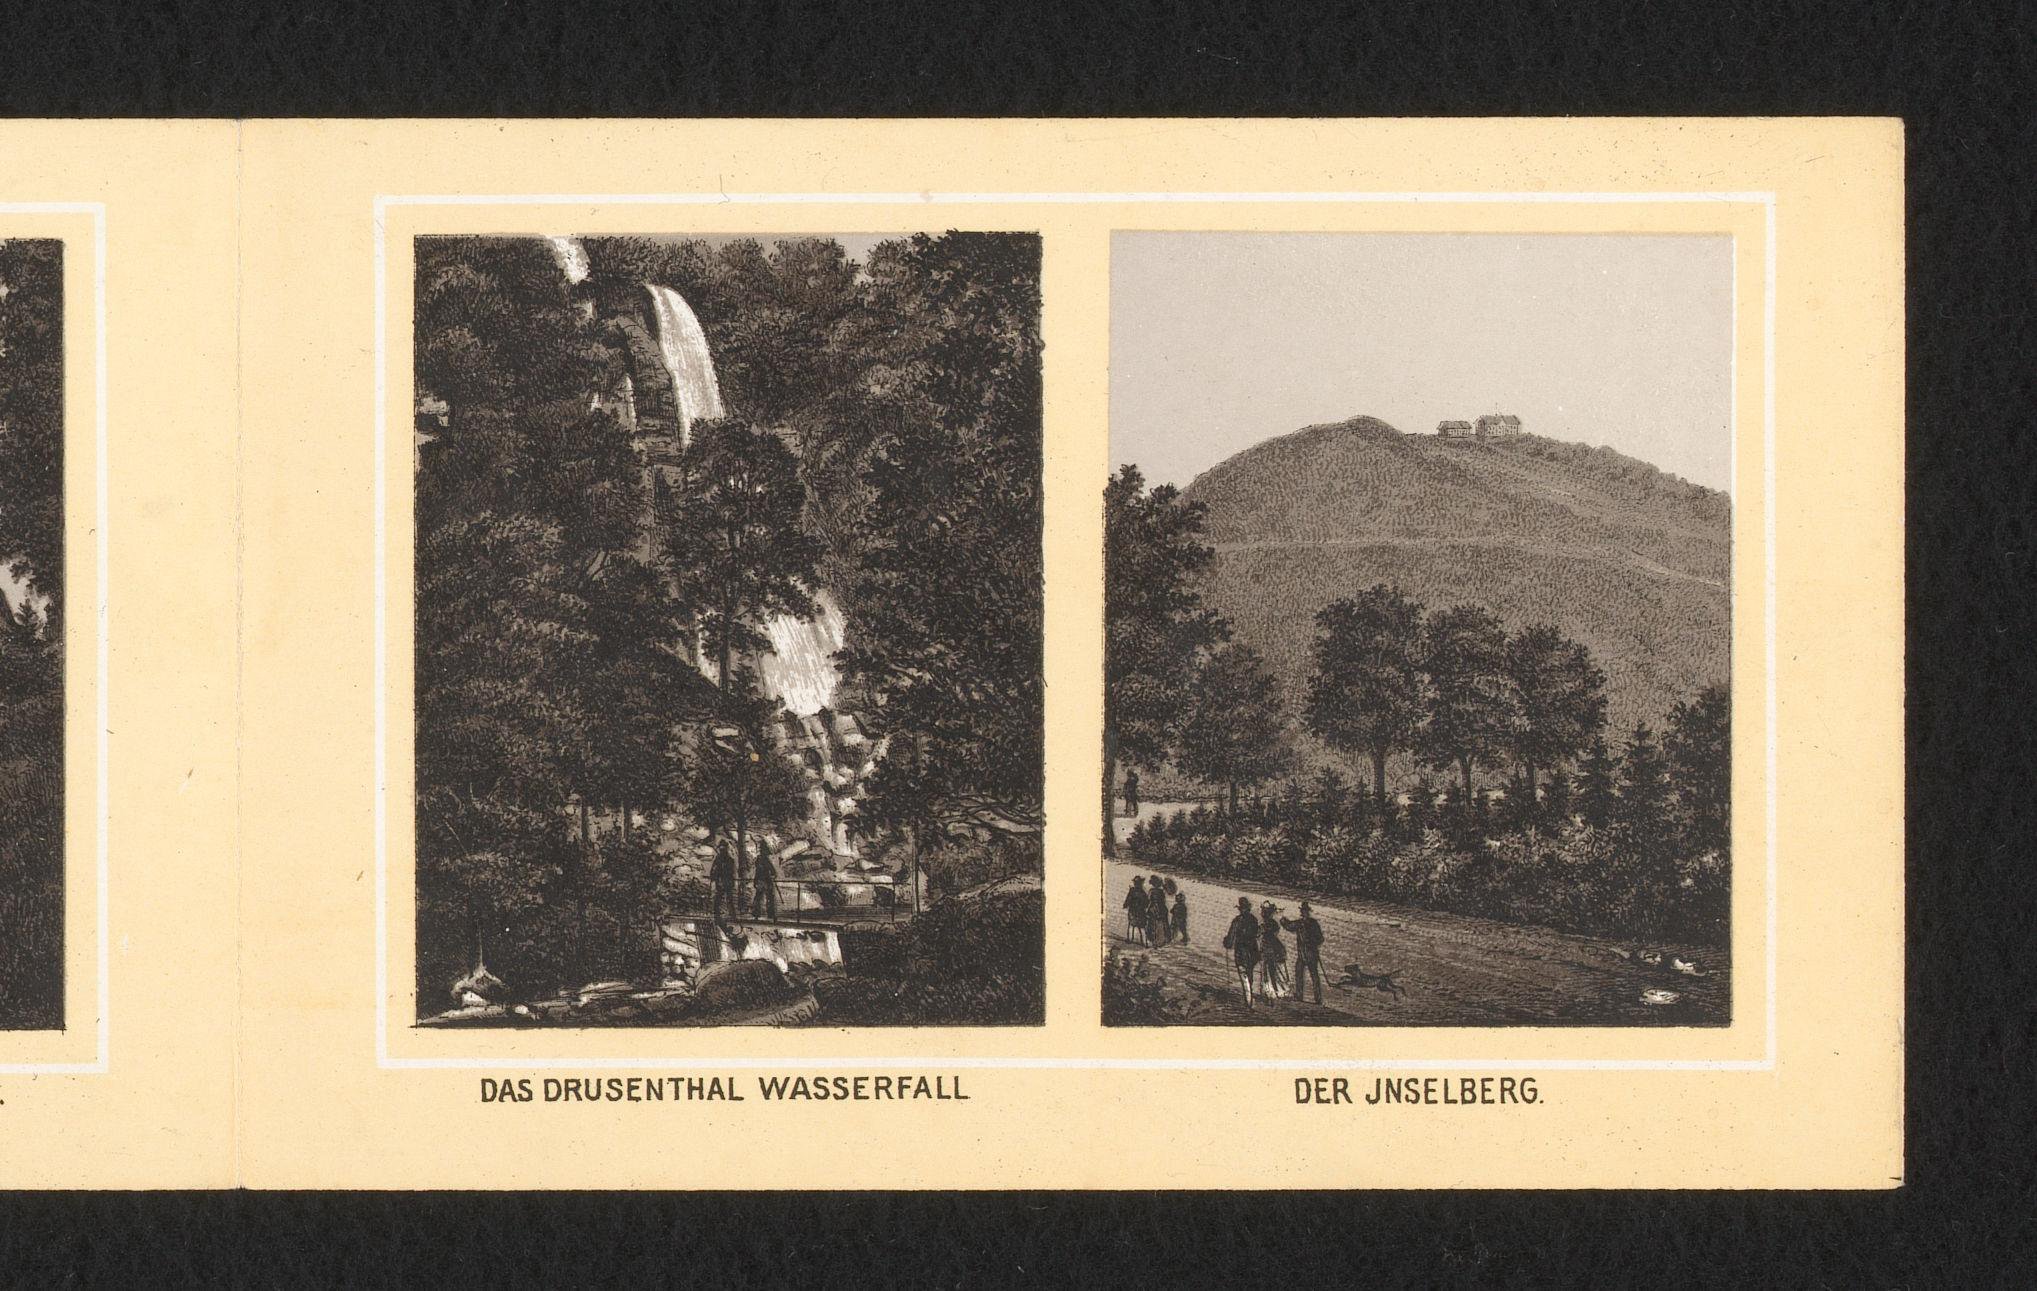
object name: ansichtkaart, prentbriefkaart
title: Das Drusenthal Wasserfall. Der Jnselberg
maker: louis glaser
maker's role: printer, publisher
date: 1874-1900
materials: cardboard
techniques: photolithography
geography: leipzig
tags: waterfall, mountains